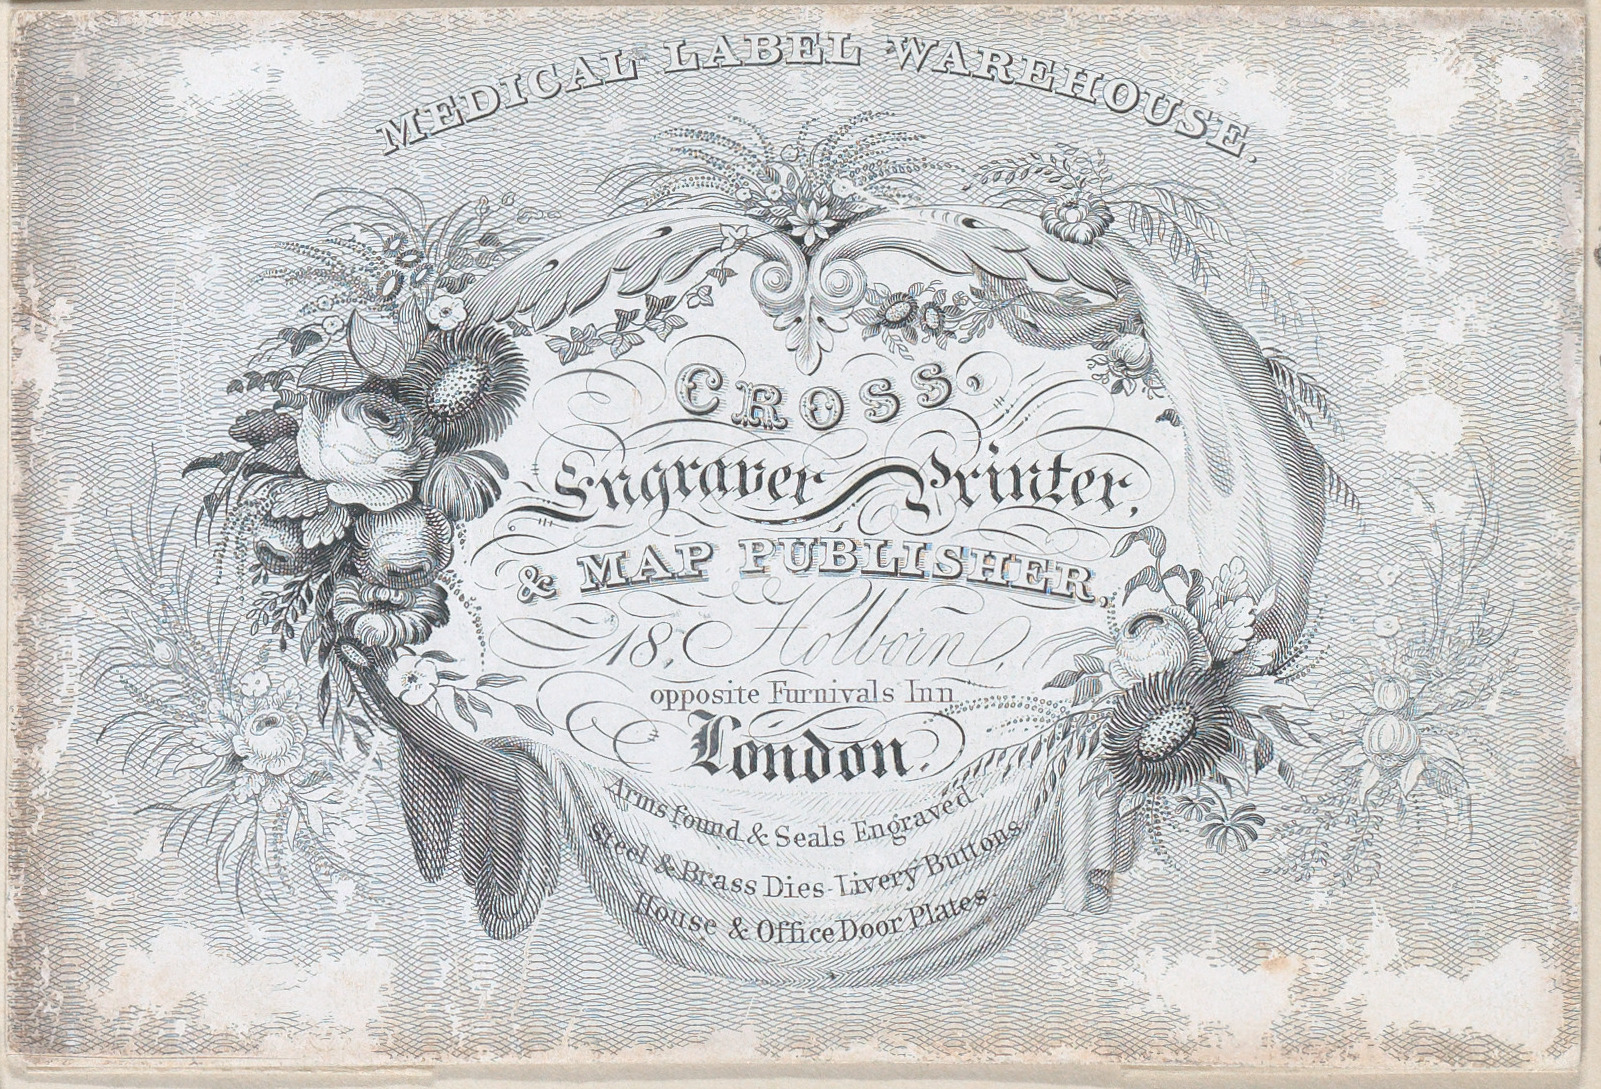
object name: print, trade card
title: Trade Card for Cross, Engraver, Print and Map Publisher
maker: anonymous, british, 19th century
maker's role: artist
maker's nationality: british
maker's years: 1800-1900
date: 1801-1900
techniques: engraving